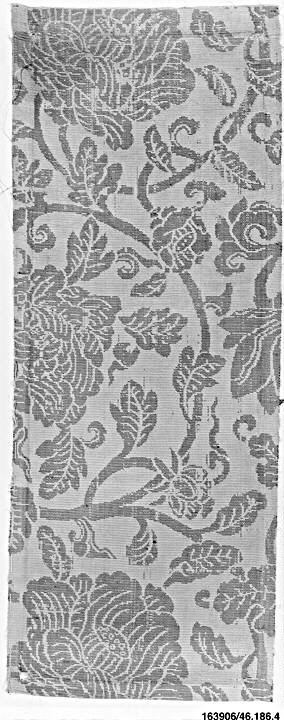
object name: sutra cover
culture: chinese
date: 1667-1733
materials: silk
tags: flowers